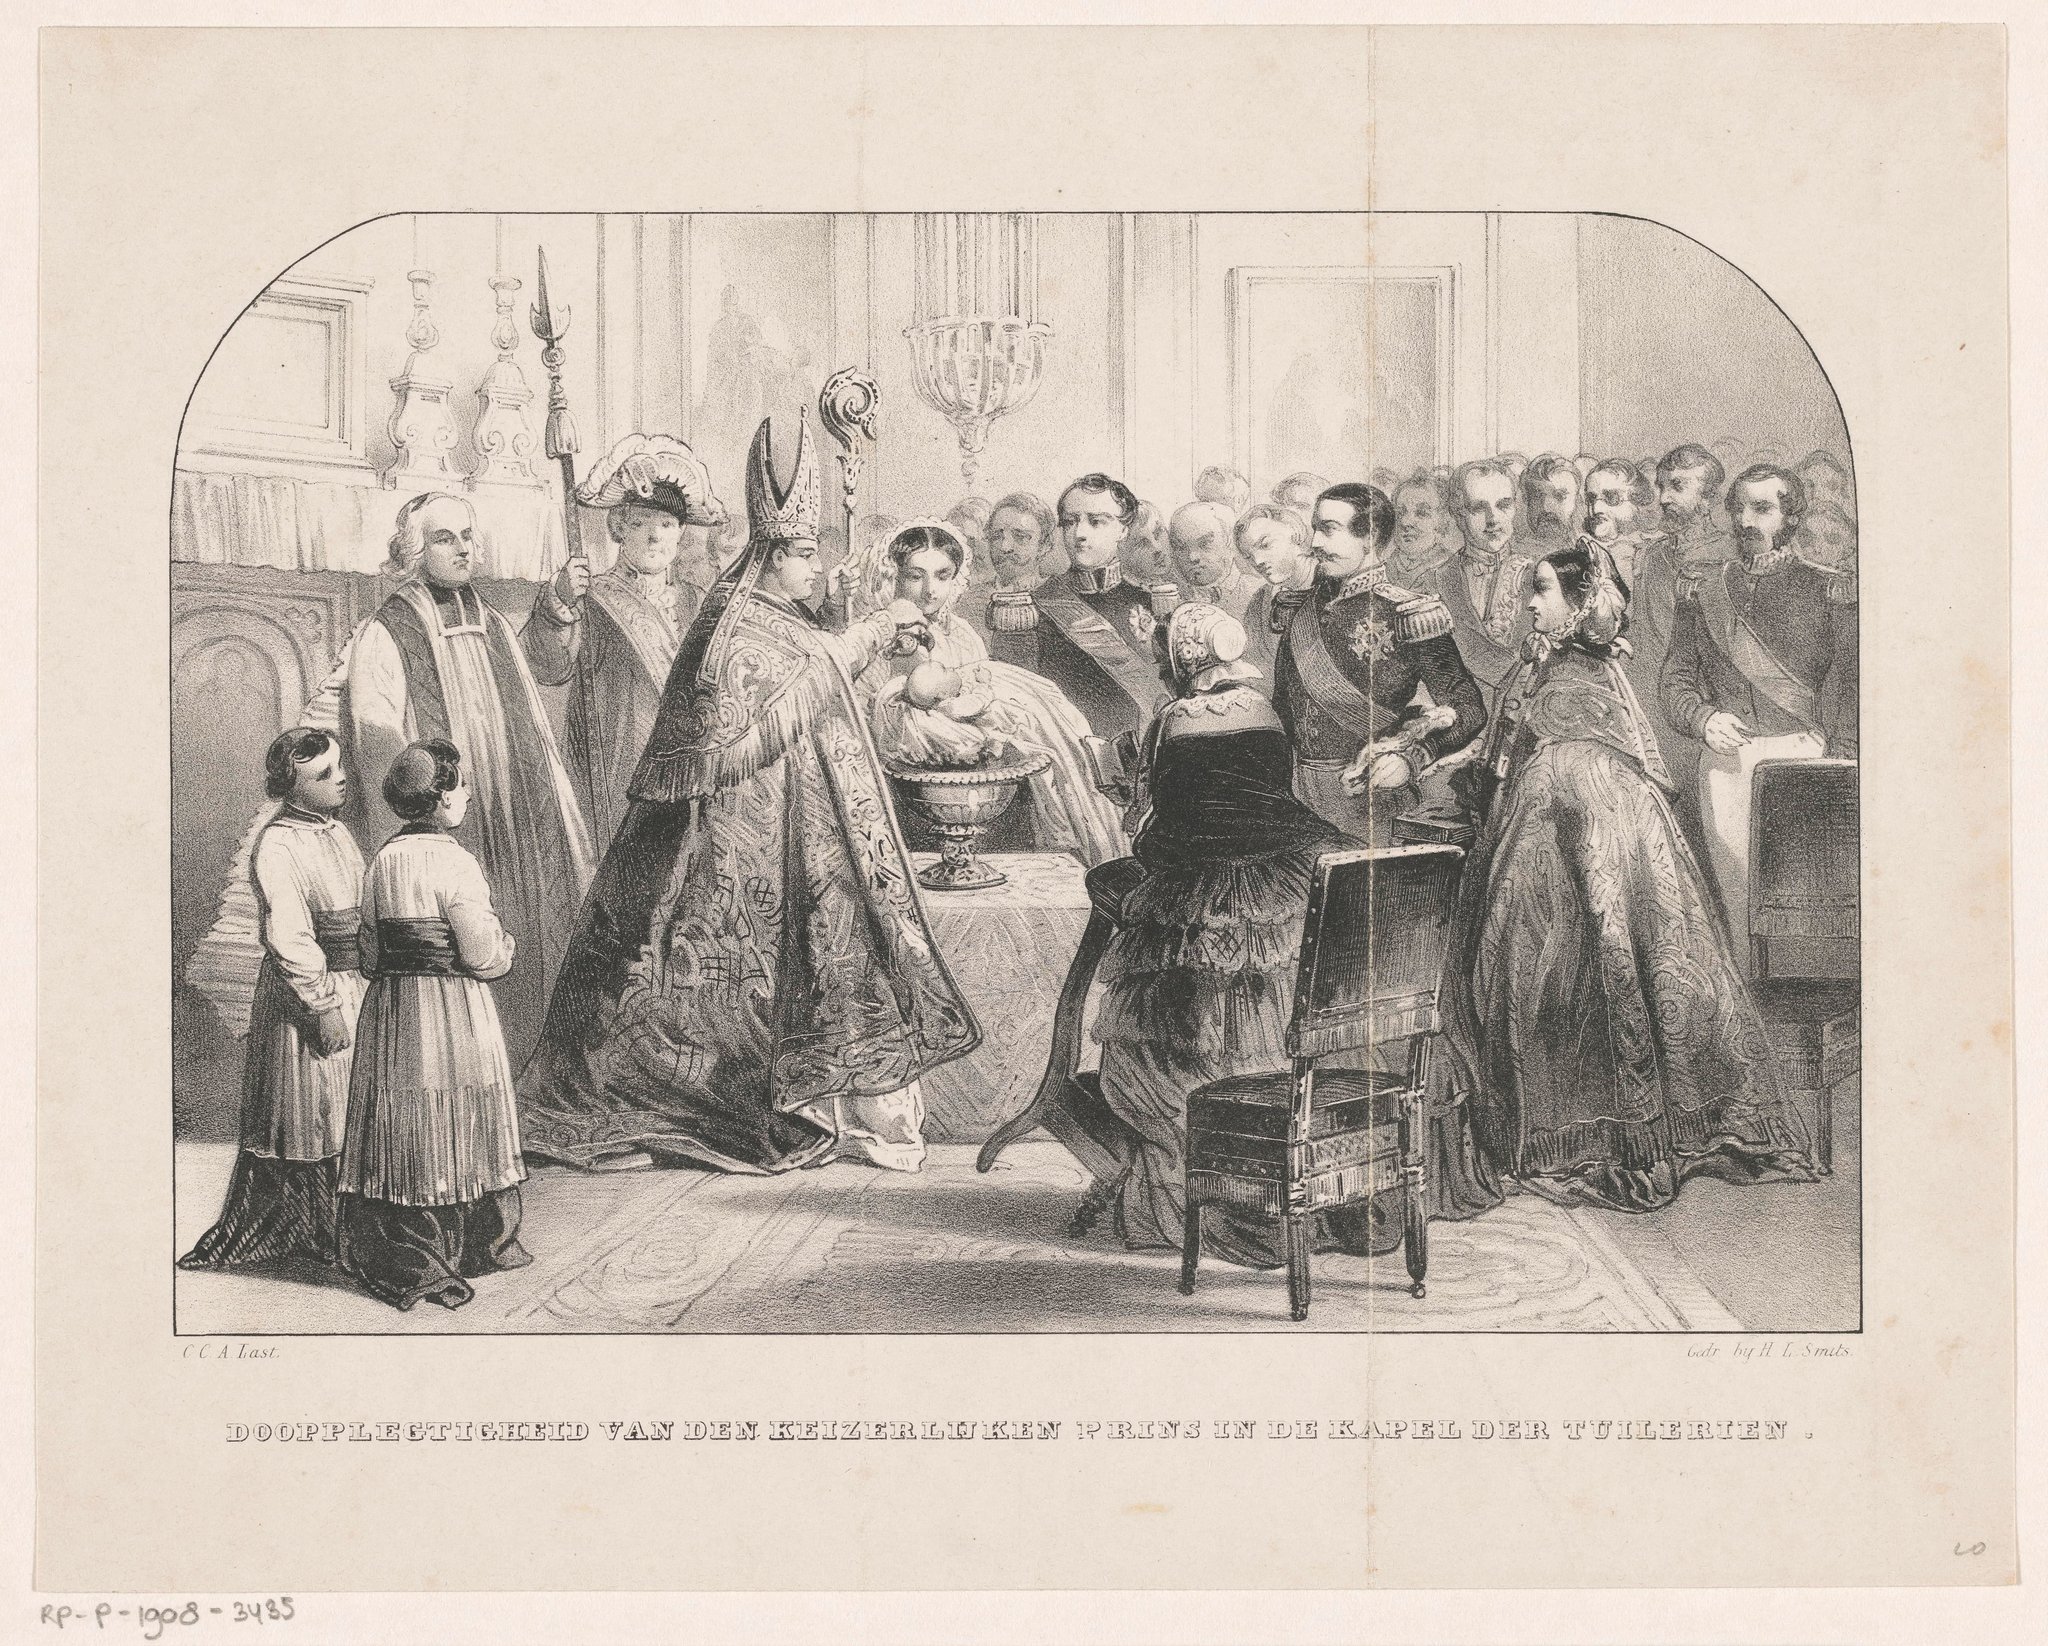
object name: print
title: Doop van Filips van Frankrijk, hertog van Orléans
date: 1818-1876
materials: paper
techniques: lithograph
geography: the hague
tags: filips i (hertog van orléans), solemn baptism (by bishop or priest)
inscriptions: collector's mark: Lugt 2228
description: De prins wordt door zijn moeder boven het doopvont gehouden. Een bisschop schenkt gewijd water over zijn hoofd. Zij zijn omringt door genodigden.